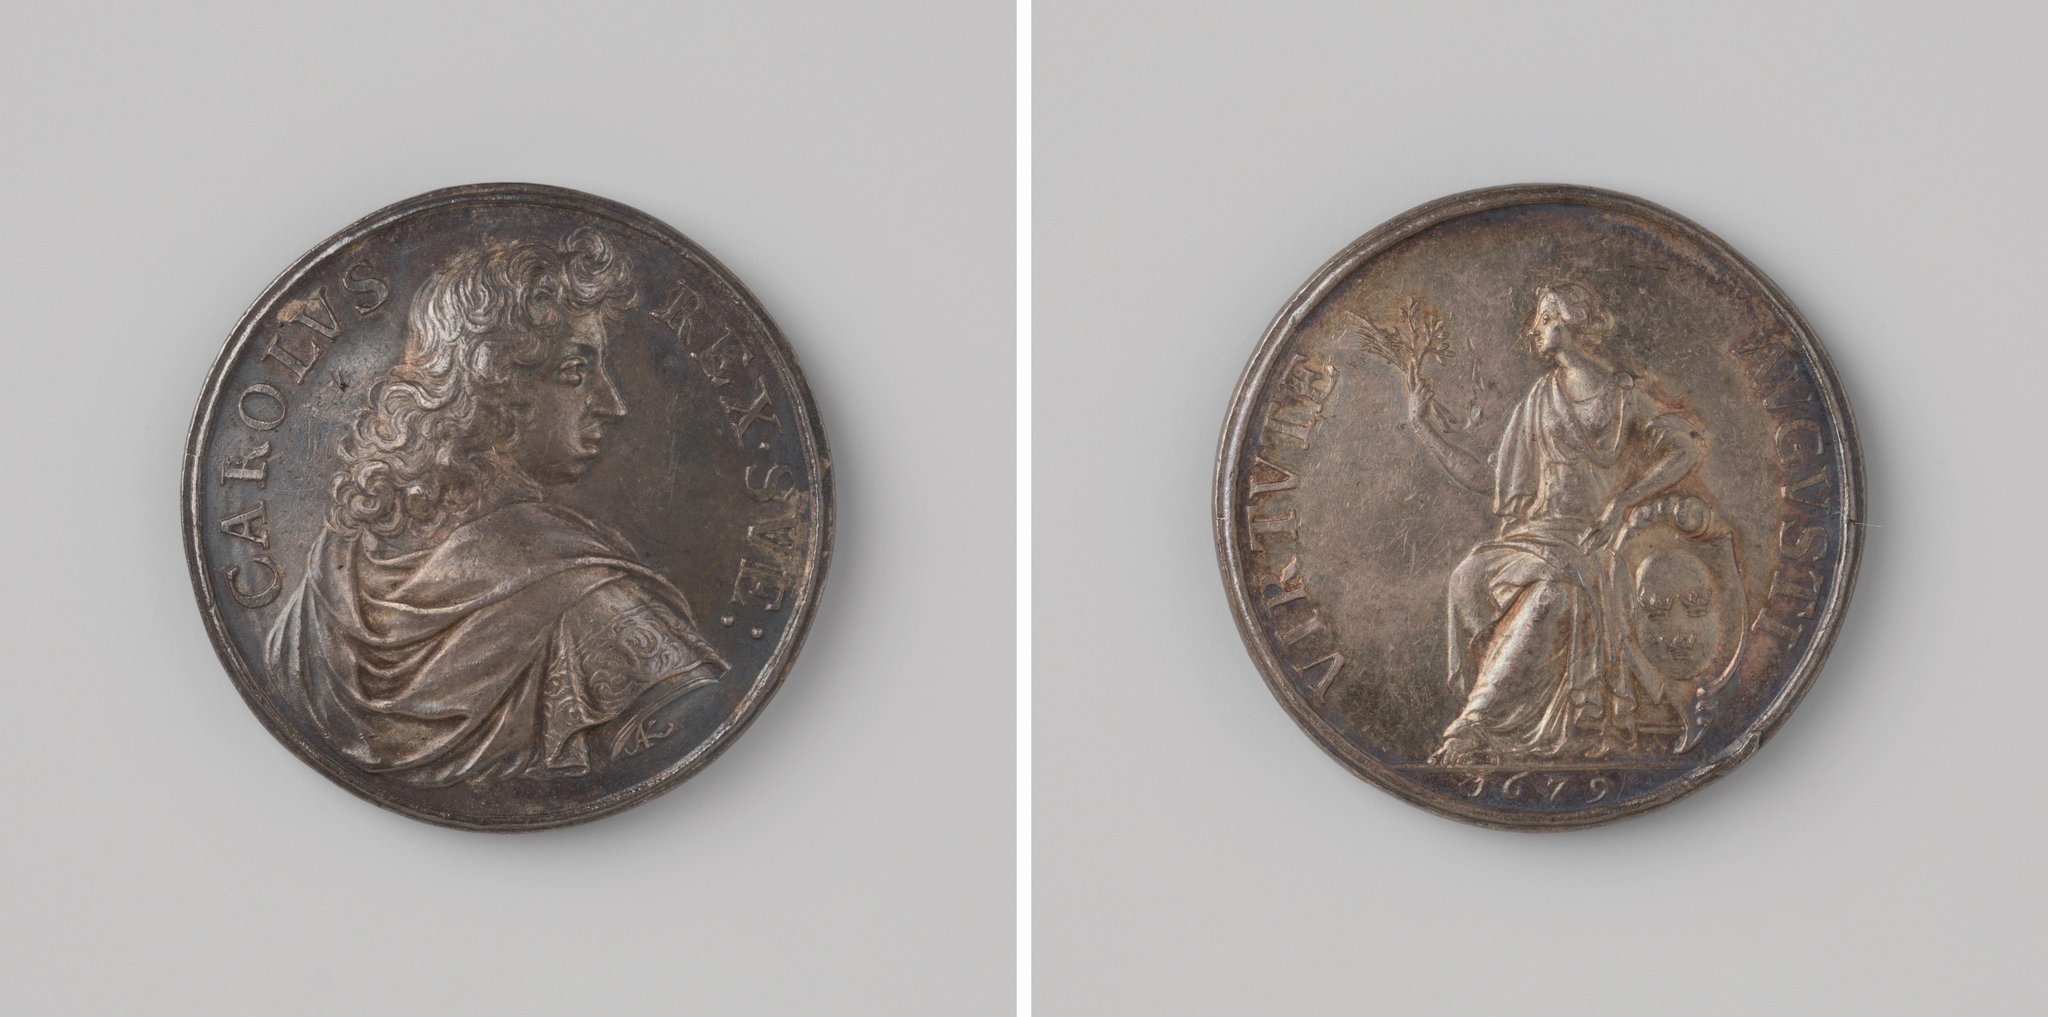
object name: history medal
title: Vrede van Fontainebleau tussen Denemarken en Zweden, ter ere van Karel XI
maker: arvid karlsteen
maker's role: medailleur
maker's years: 1647-1718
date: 1679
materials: silver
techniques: striking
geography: stockholm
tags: koning, karel xi (koning van zweden), île-de-france, fontainebleau, vrede van fontainebleau (1679)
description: Zilveren penning. Voorzijde: borststuk man binnen omschrift. Keerzijde: Zweden in gedaante van jonge vrouw met olijftak en schild met drie kronen binnen omschrift; afsnede: jaartal.